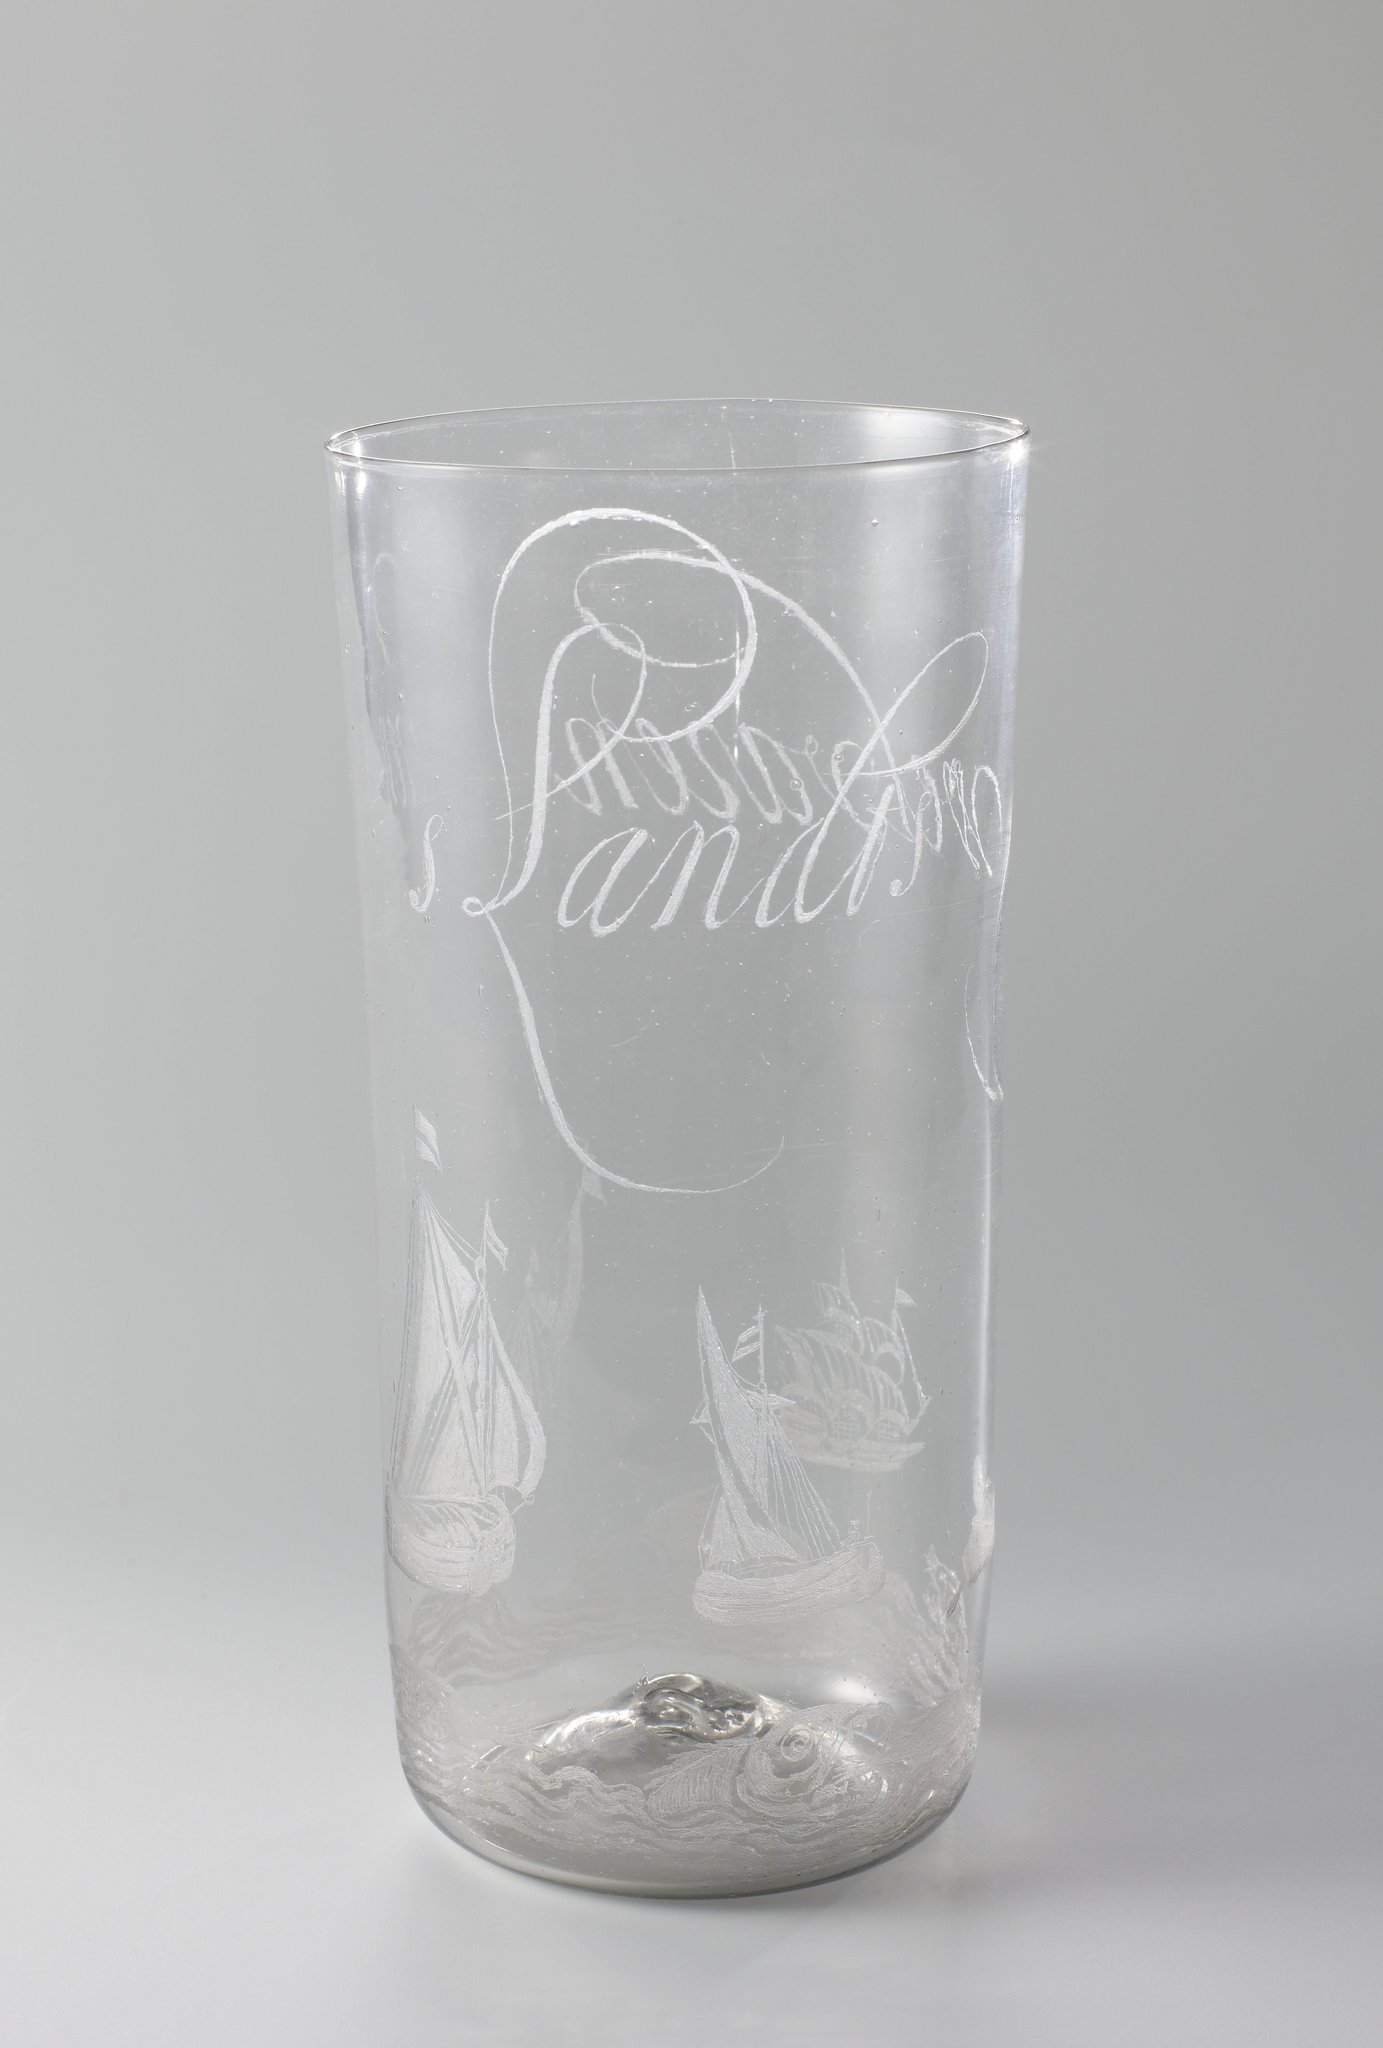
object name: cup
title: Beaker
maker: Anonymous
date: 1660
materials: glass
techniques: diamond point engraving, façon de venise, glassblowing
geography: northern netherlands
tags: sailing-ship, sailing-boat, fishes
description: The engraving on this beaker represents ships at sea, with an inscription that translates as: ‘To the Prosperity of the Country’.